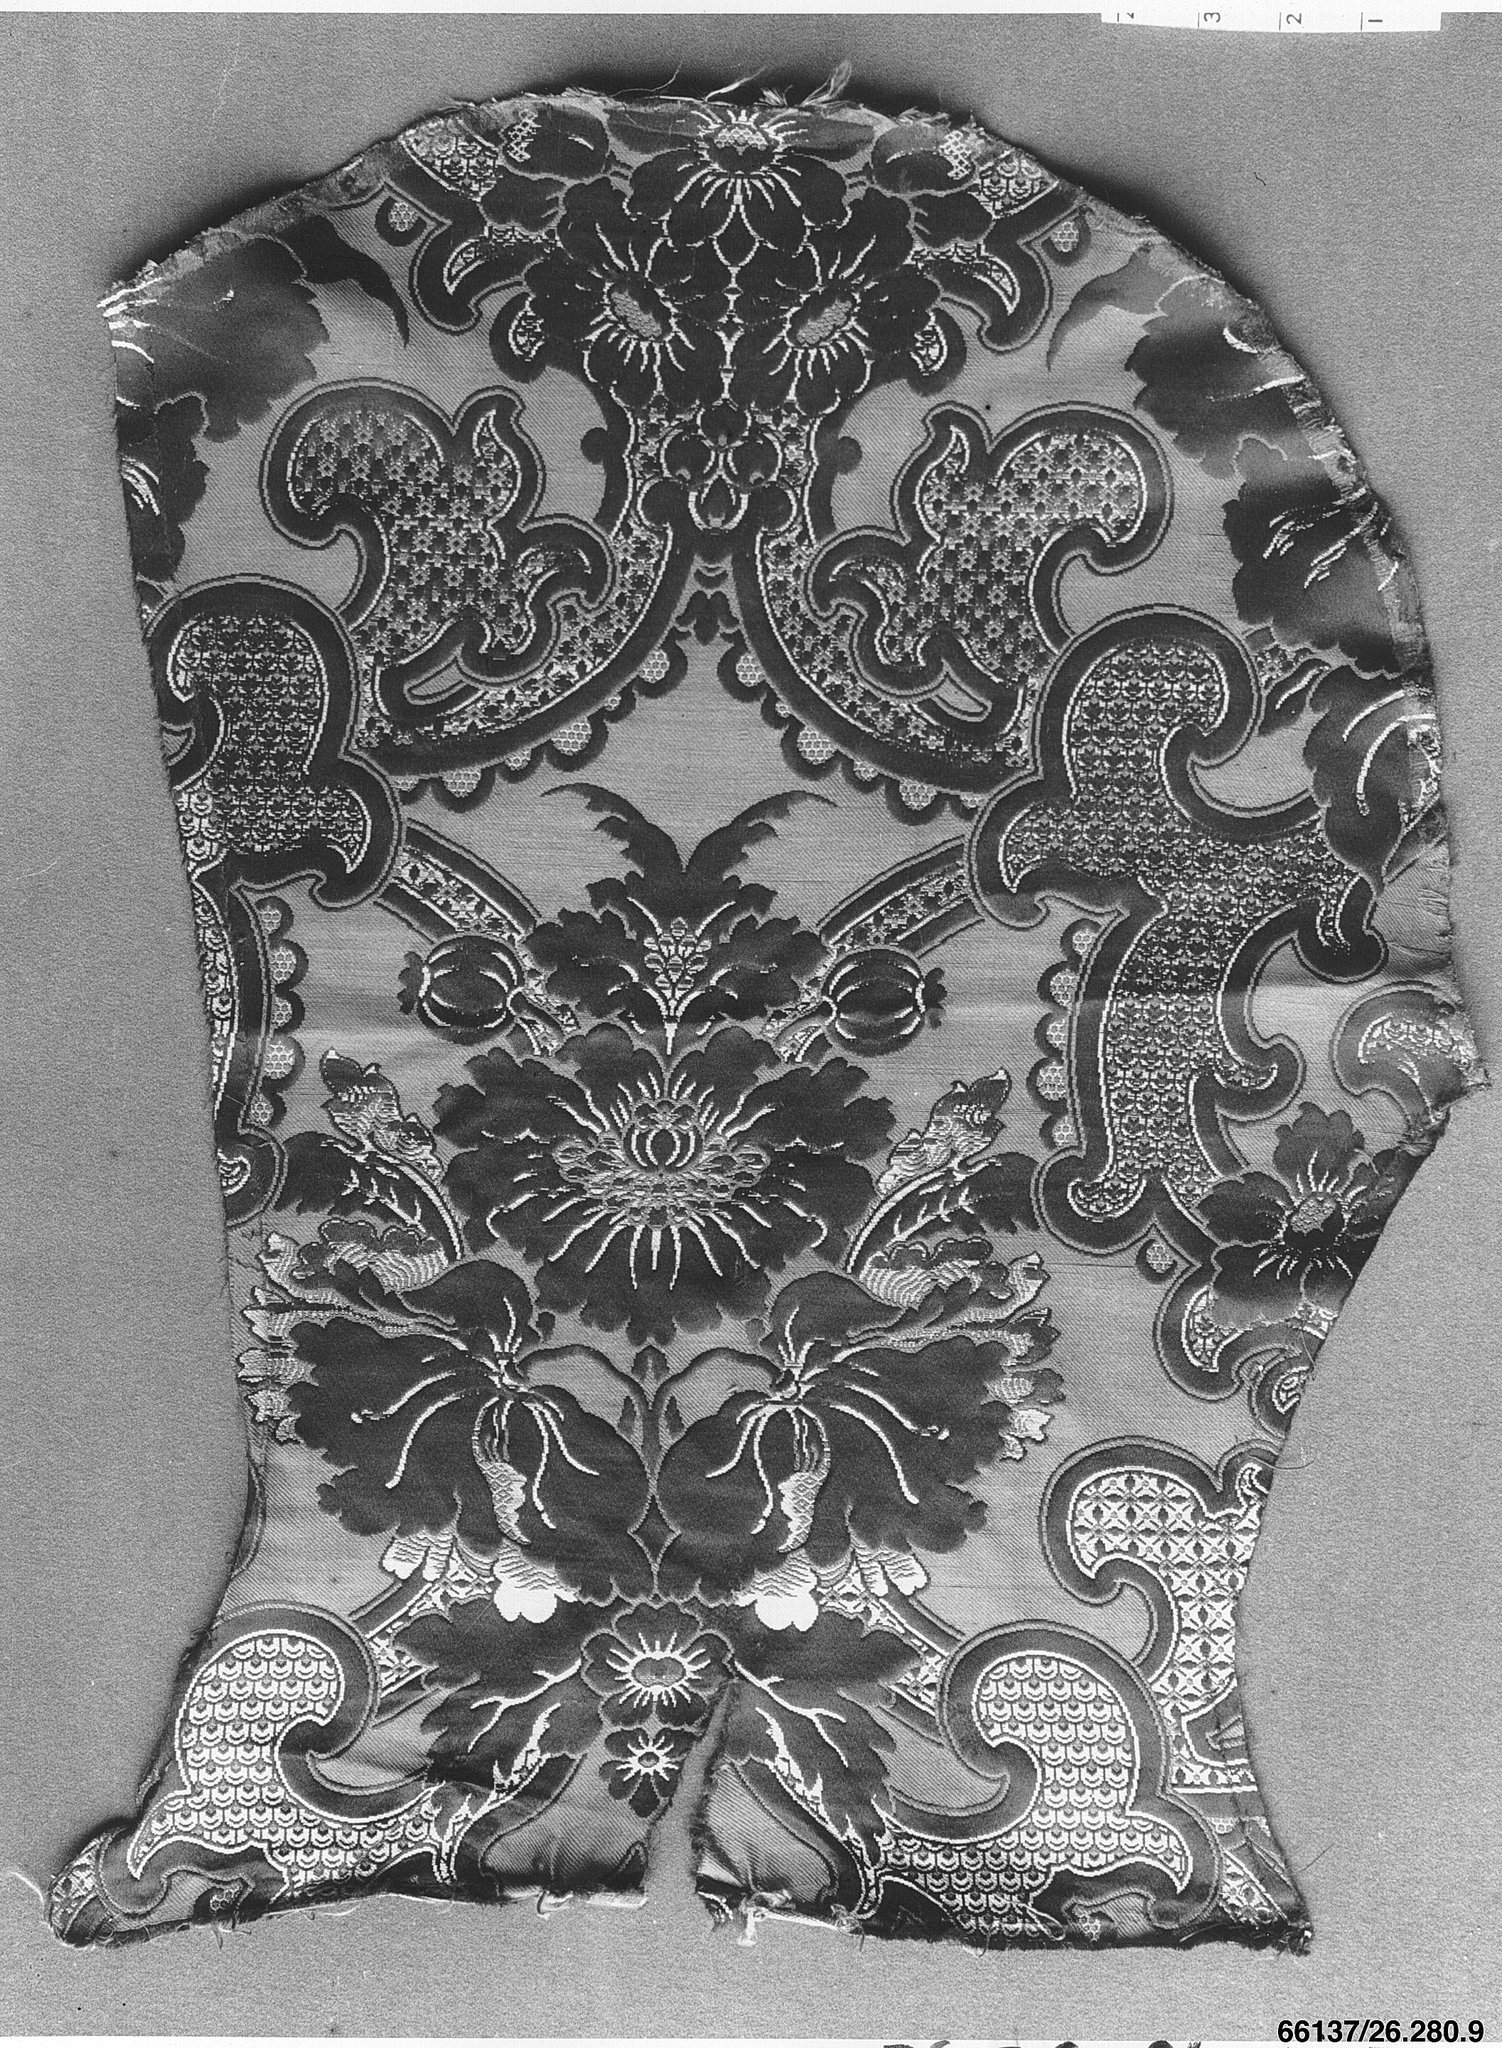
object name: piece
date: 1848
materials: silk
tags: flowers